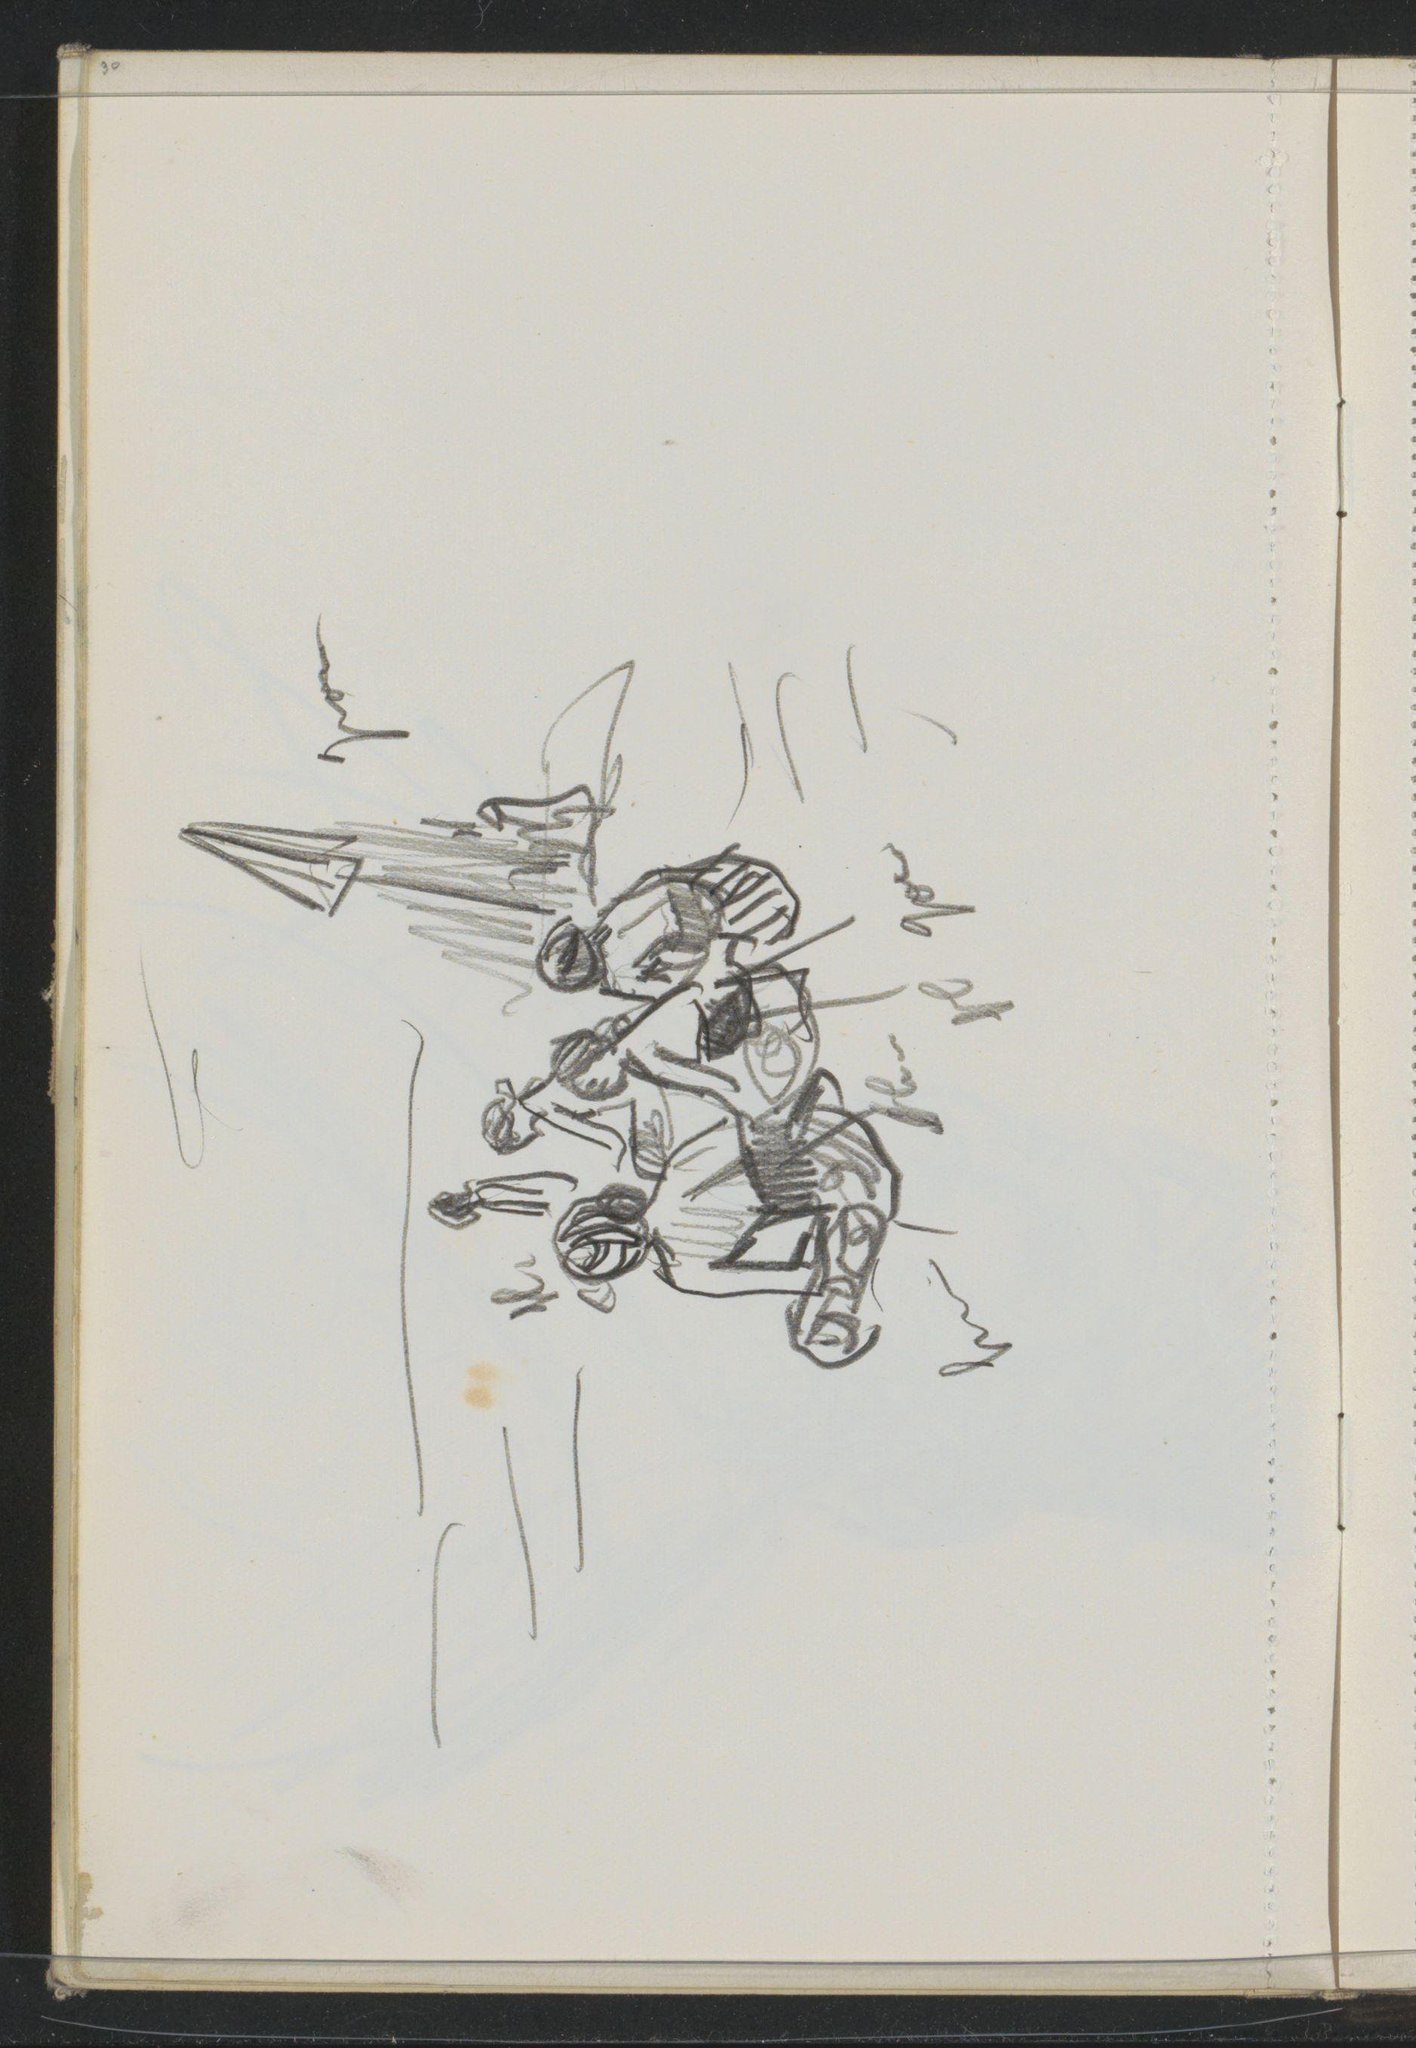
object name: sketchbook leaf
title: Zittende serimpies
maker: marius bauer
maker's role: draughtsman, print maker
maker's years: 1867-1932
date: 1925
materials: paper, pencil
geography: indonesia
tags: sitting figure, female dancer, folk costume, regional costume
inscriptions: kleurnotitie, handgeschreven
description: Pagina 30 uit een schetsboek met 74 bladen.